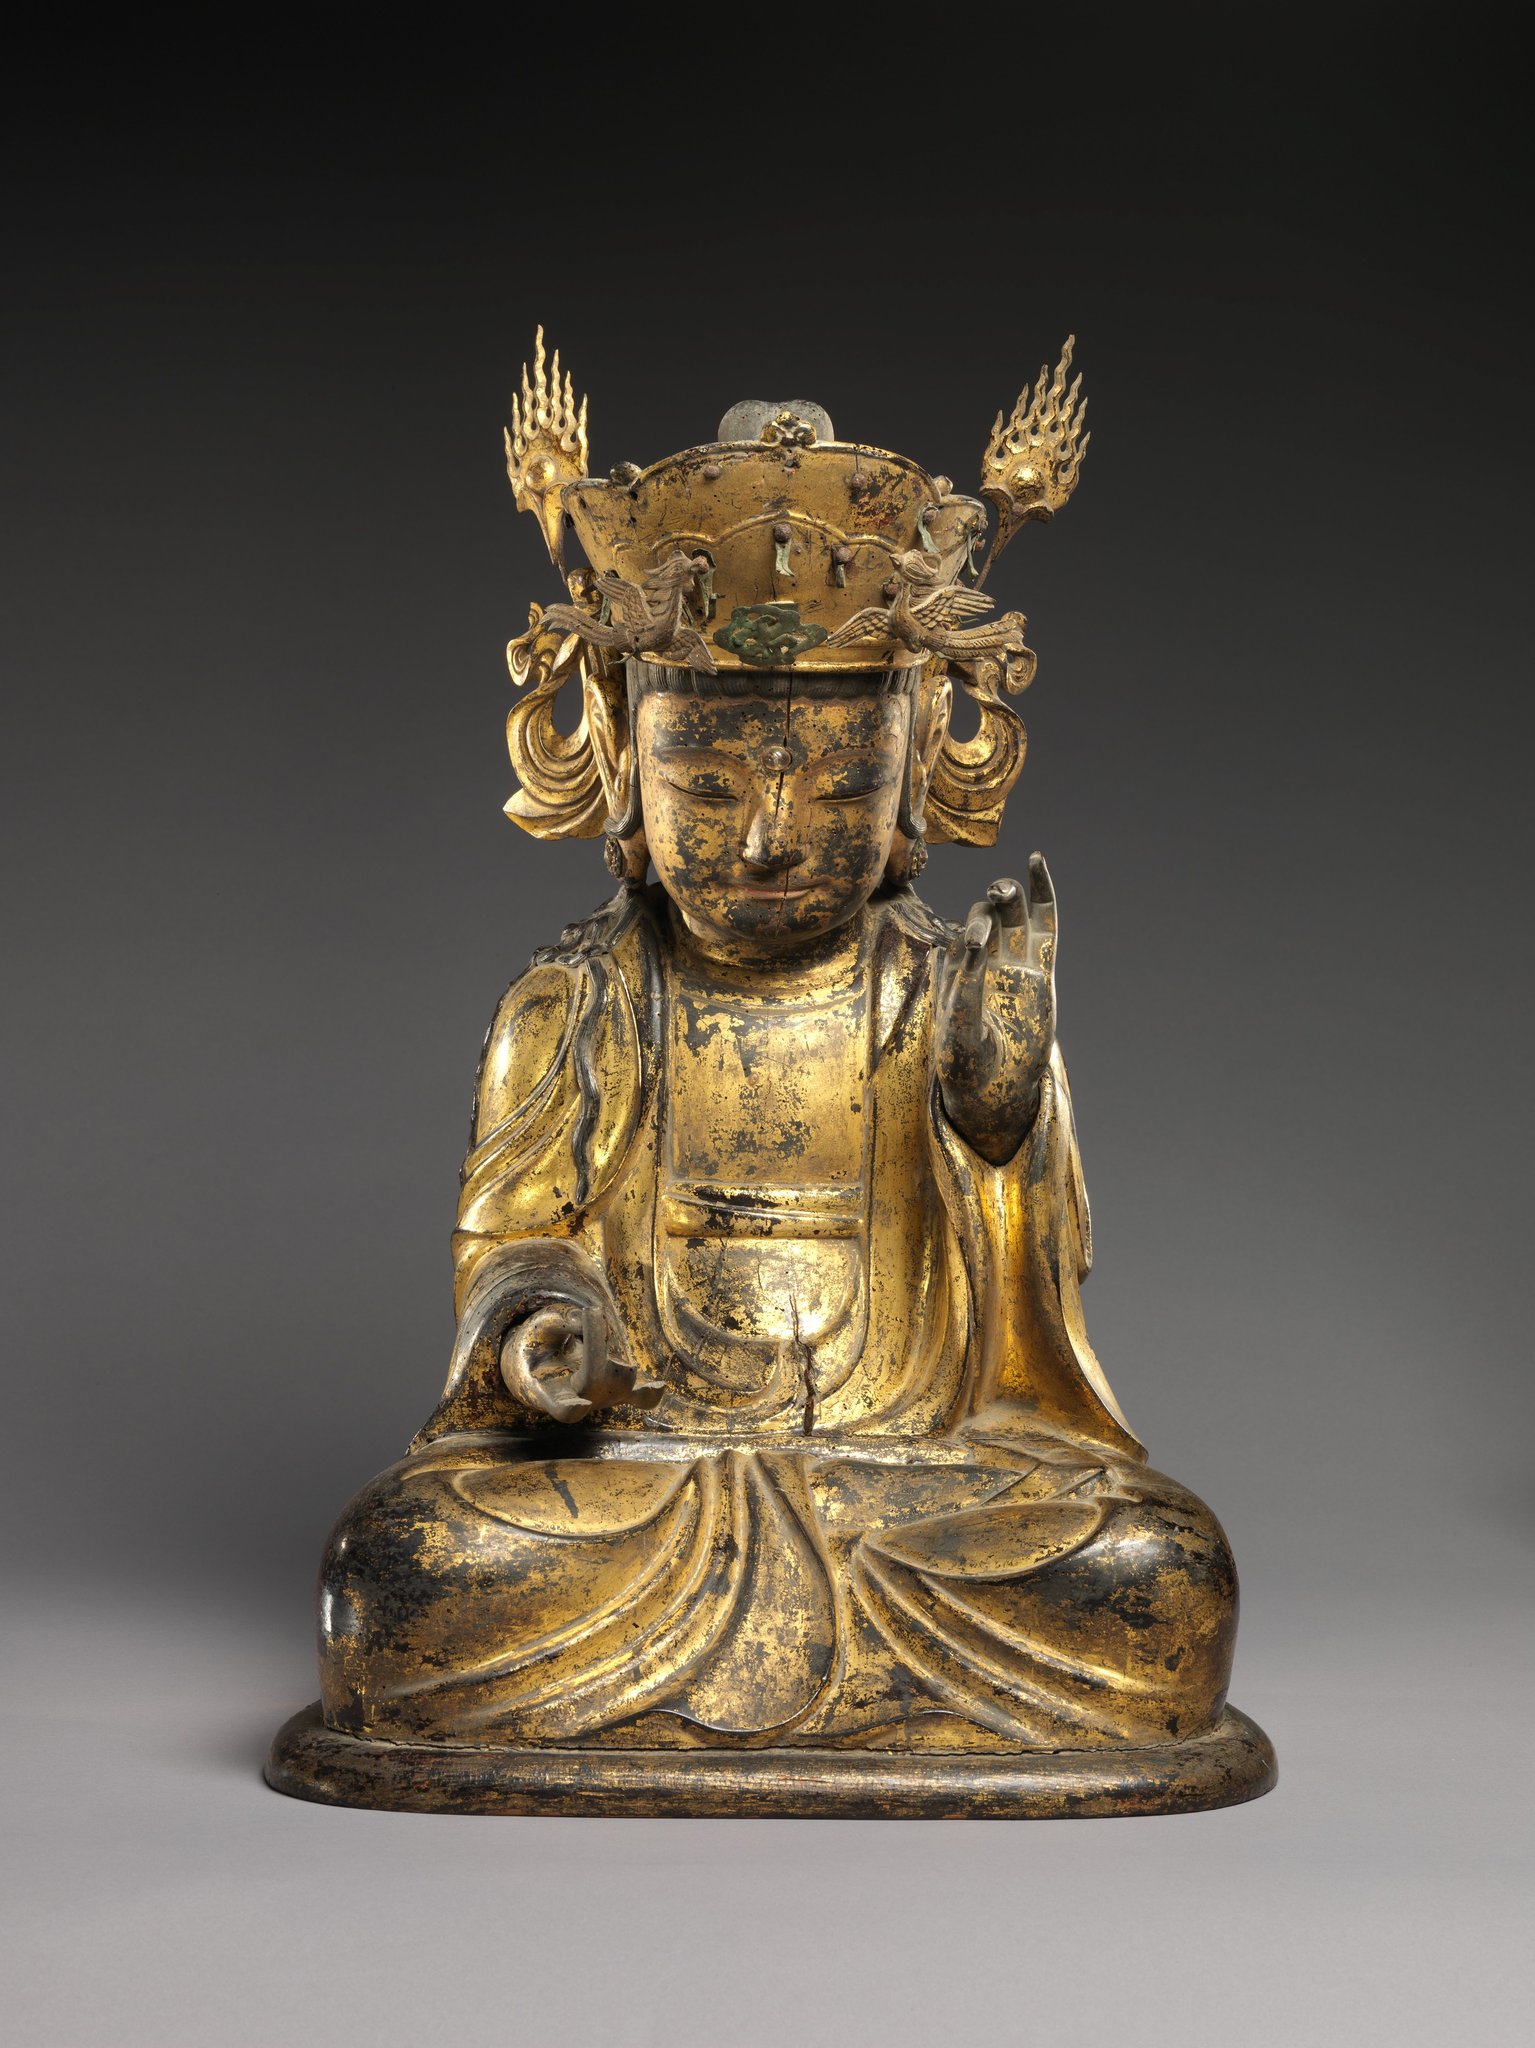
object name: statue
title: Seated bodhisattva (left attendant of a triad)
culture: korean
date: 1634-1666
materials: gilt, wood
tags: buddhism,bodhisattvas